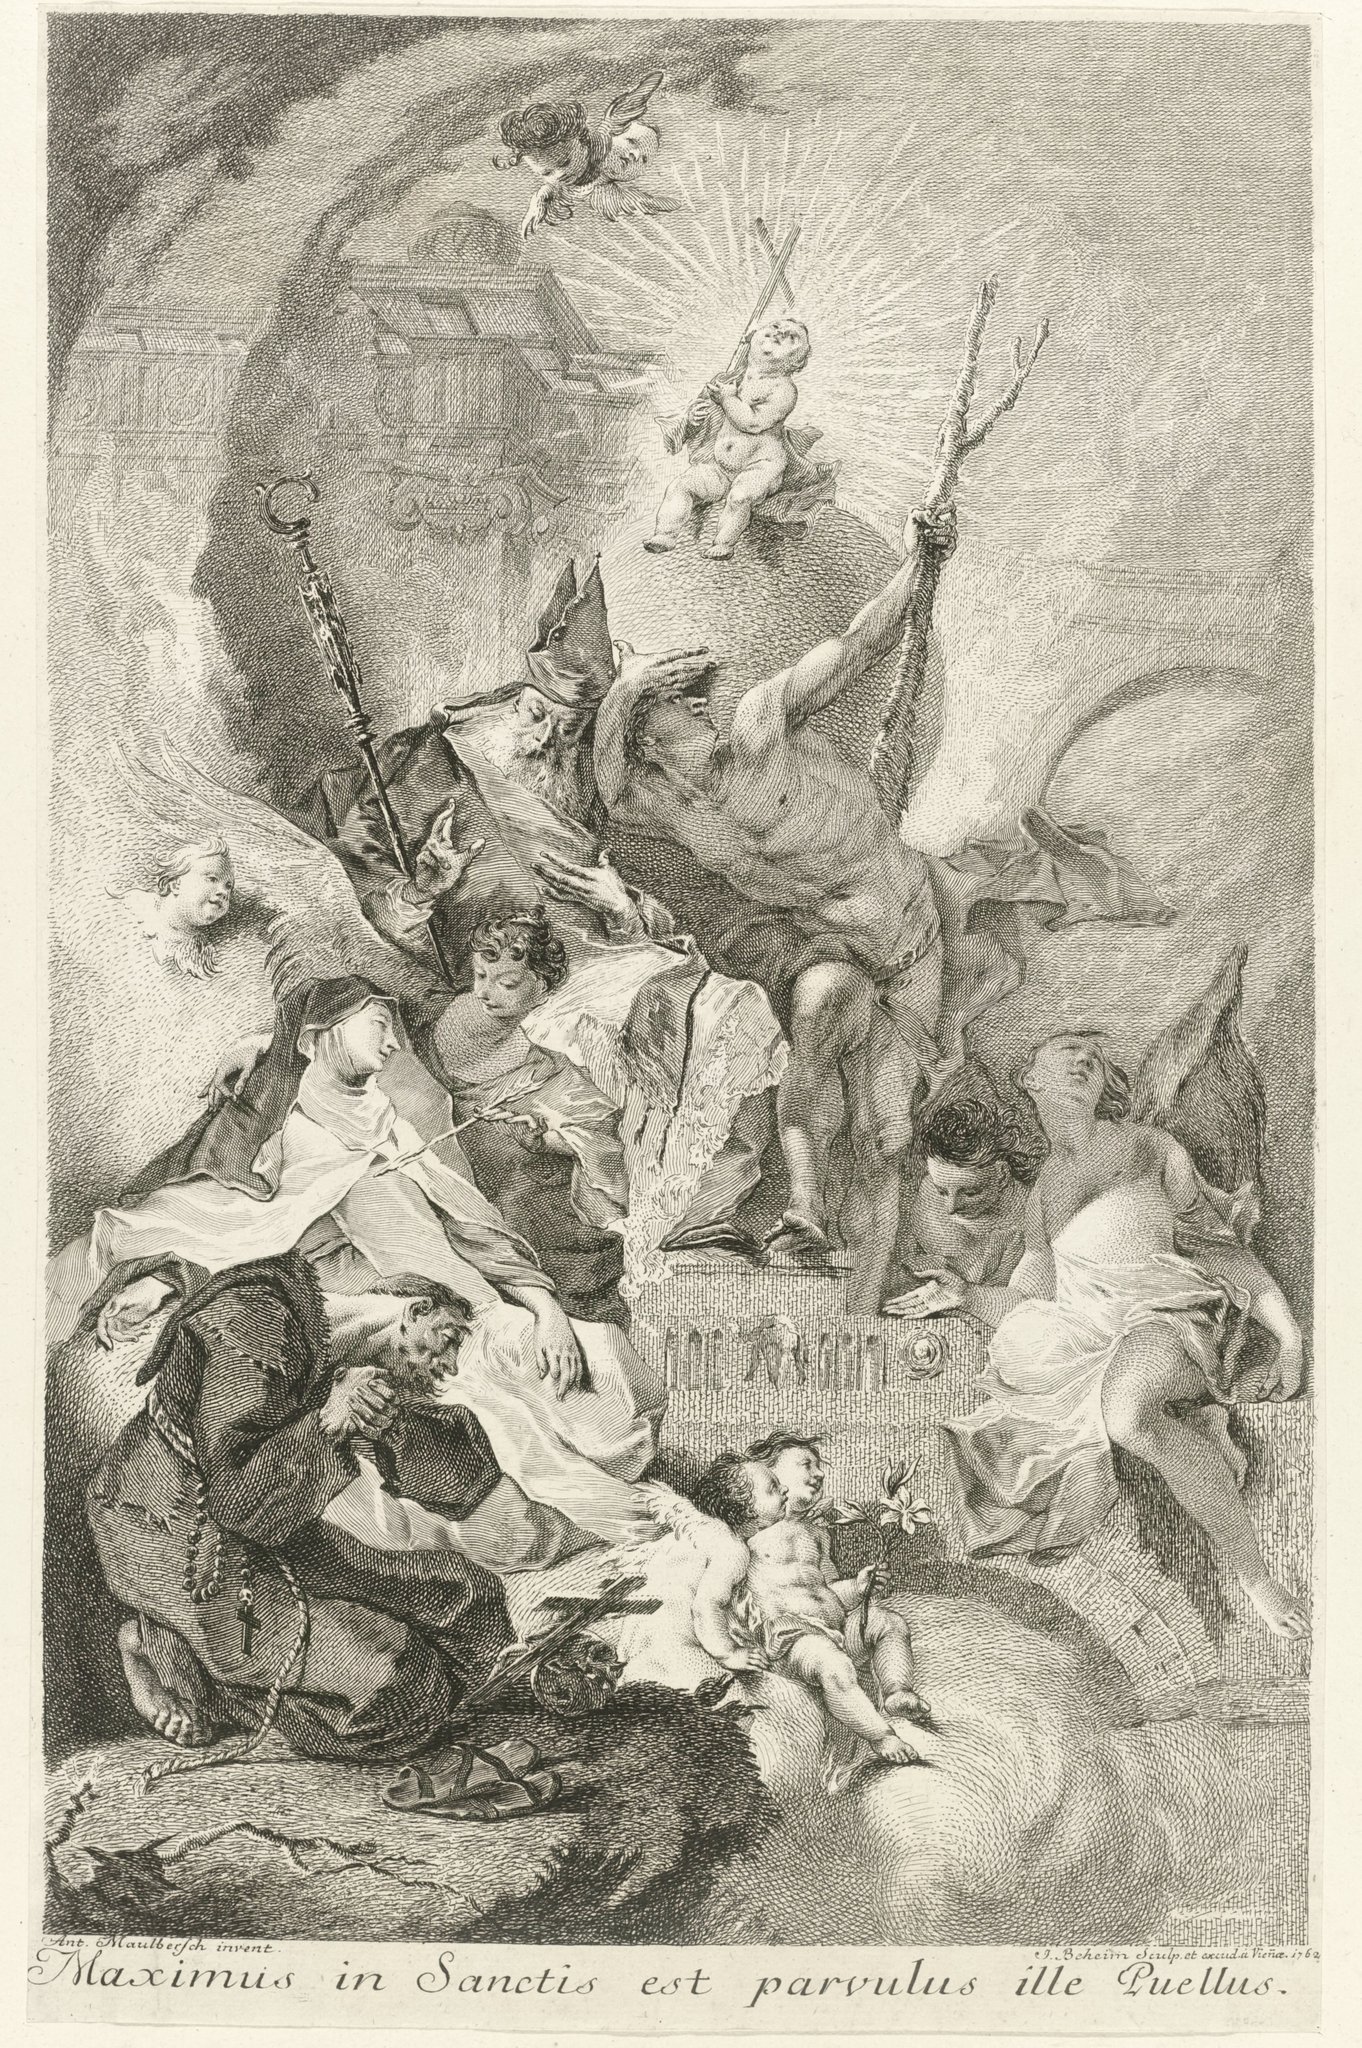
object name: print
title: Het Christuskind als Salvator Mundi met verscheidene heiligen en paus Clemens XIII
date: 1762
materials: paper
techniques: engraving, etching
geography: vienna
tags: clemens xiii, the foundress of the reformed (discalced) carmelites, t(h)eres(i)a of avila; possible attributes: angel, arrow, dove, heart (flaming or pierced by an arrow), christ-child ~ types of adult christ (+ donor(s), supplicant(s), whether or not with patron saint(s)), the jesuit missionary francis xavier; possible attributes: cross, crucifix, flaming heart, indian, lily, torch, christ-child together with others, the giant and martyr christophorus; possible attributes: palm-tree (with bunches of dates, or withered), infant christ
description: Het Christuskind met kruis gezeten op een wereldbol met daaronder de heiligen Franciscus Seraphikus, Christophorus, Theresa van Avila en paus Clemens XIII.